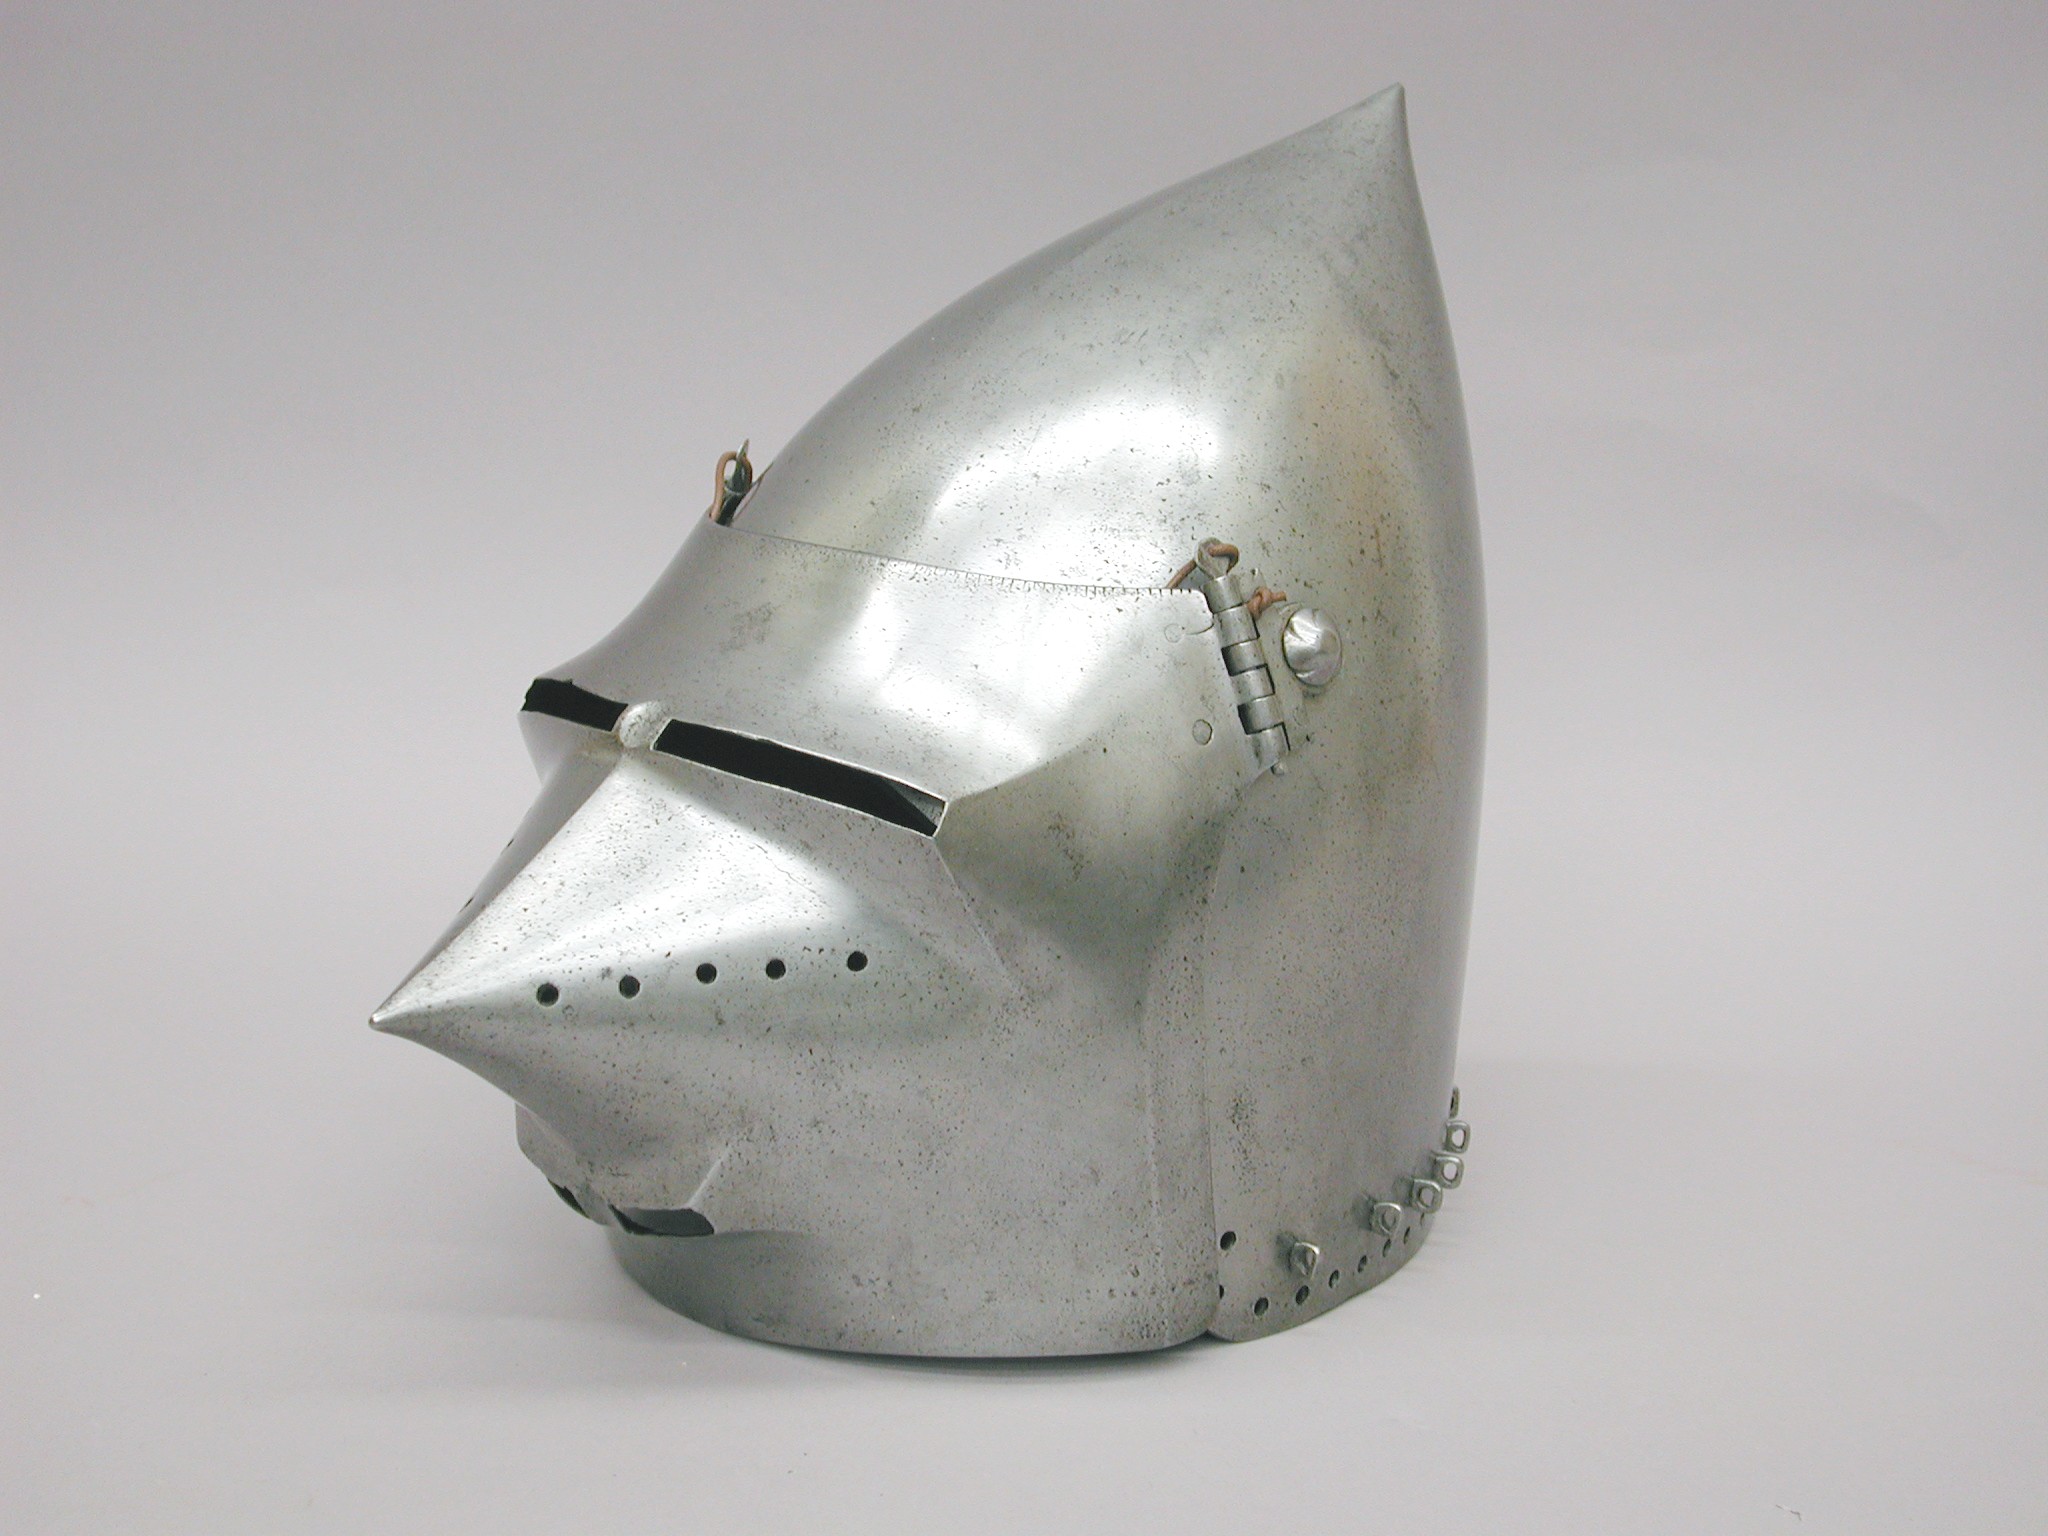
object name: visored bascinet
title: Visored Bascinet in the 14th century style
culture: french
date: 1801-1900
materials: steel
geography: france